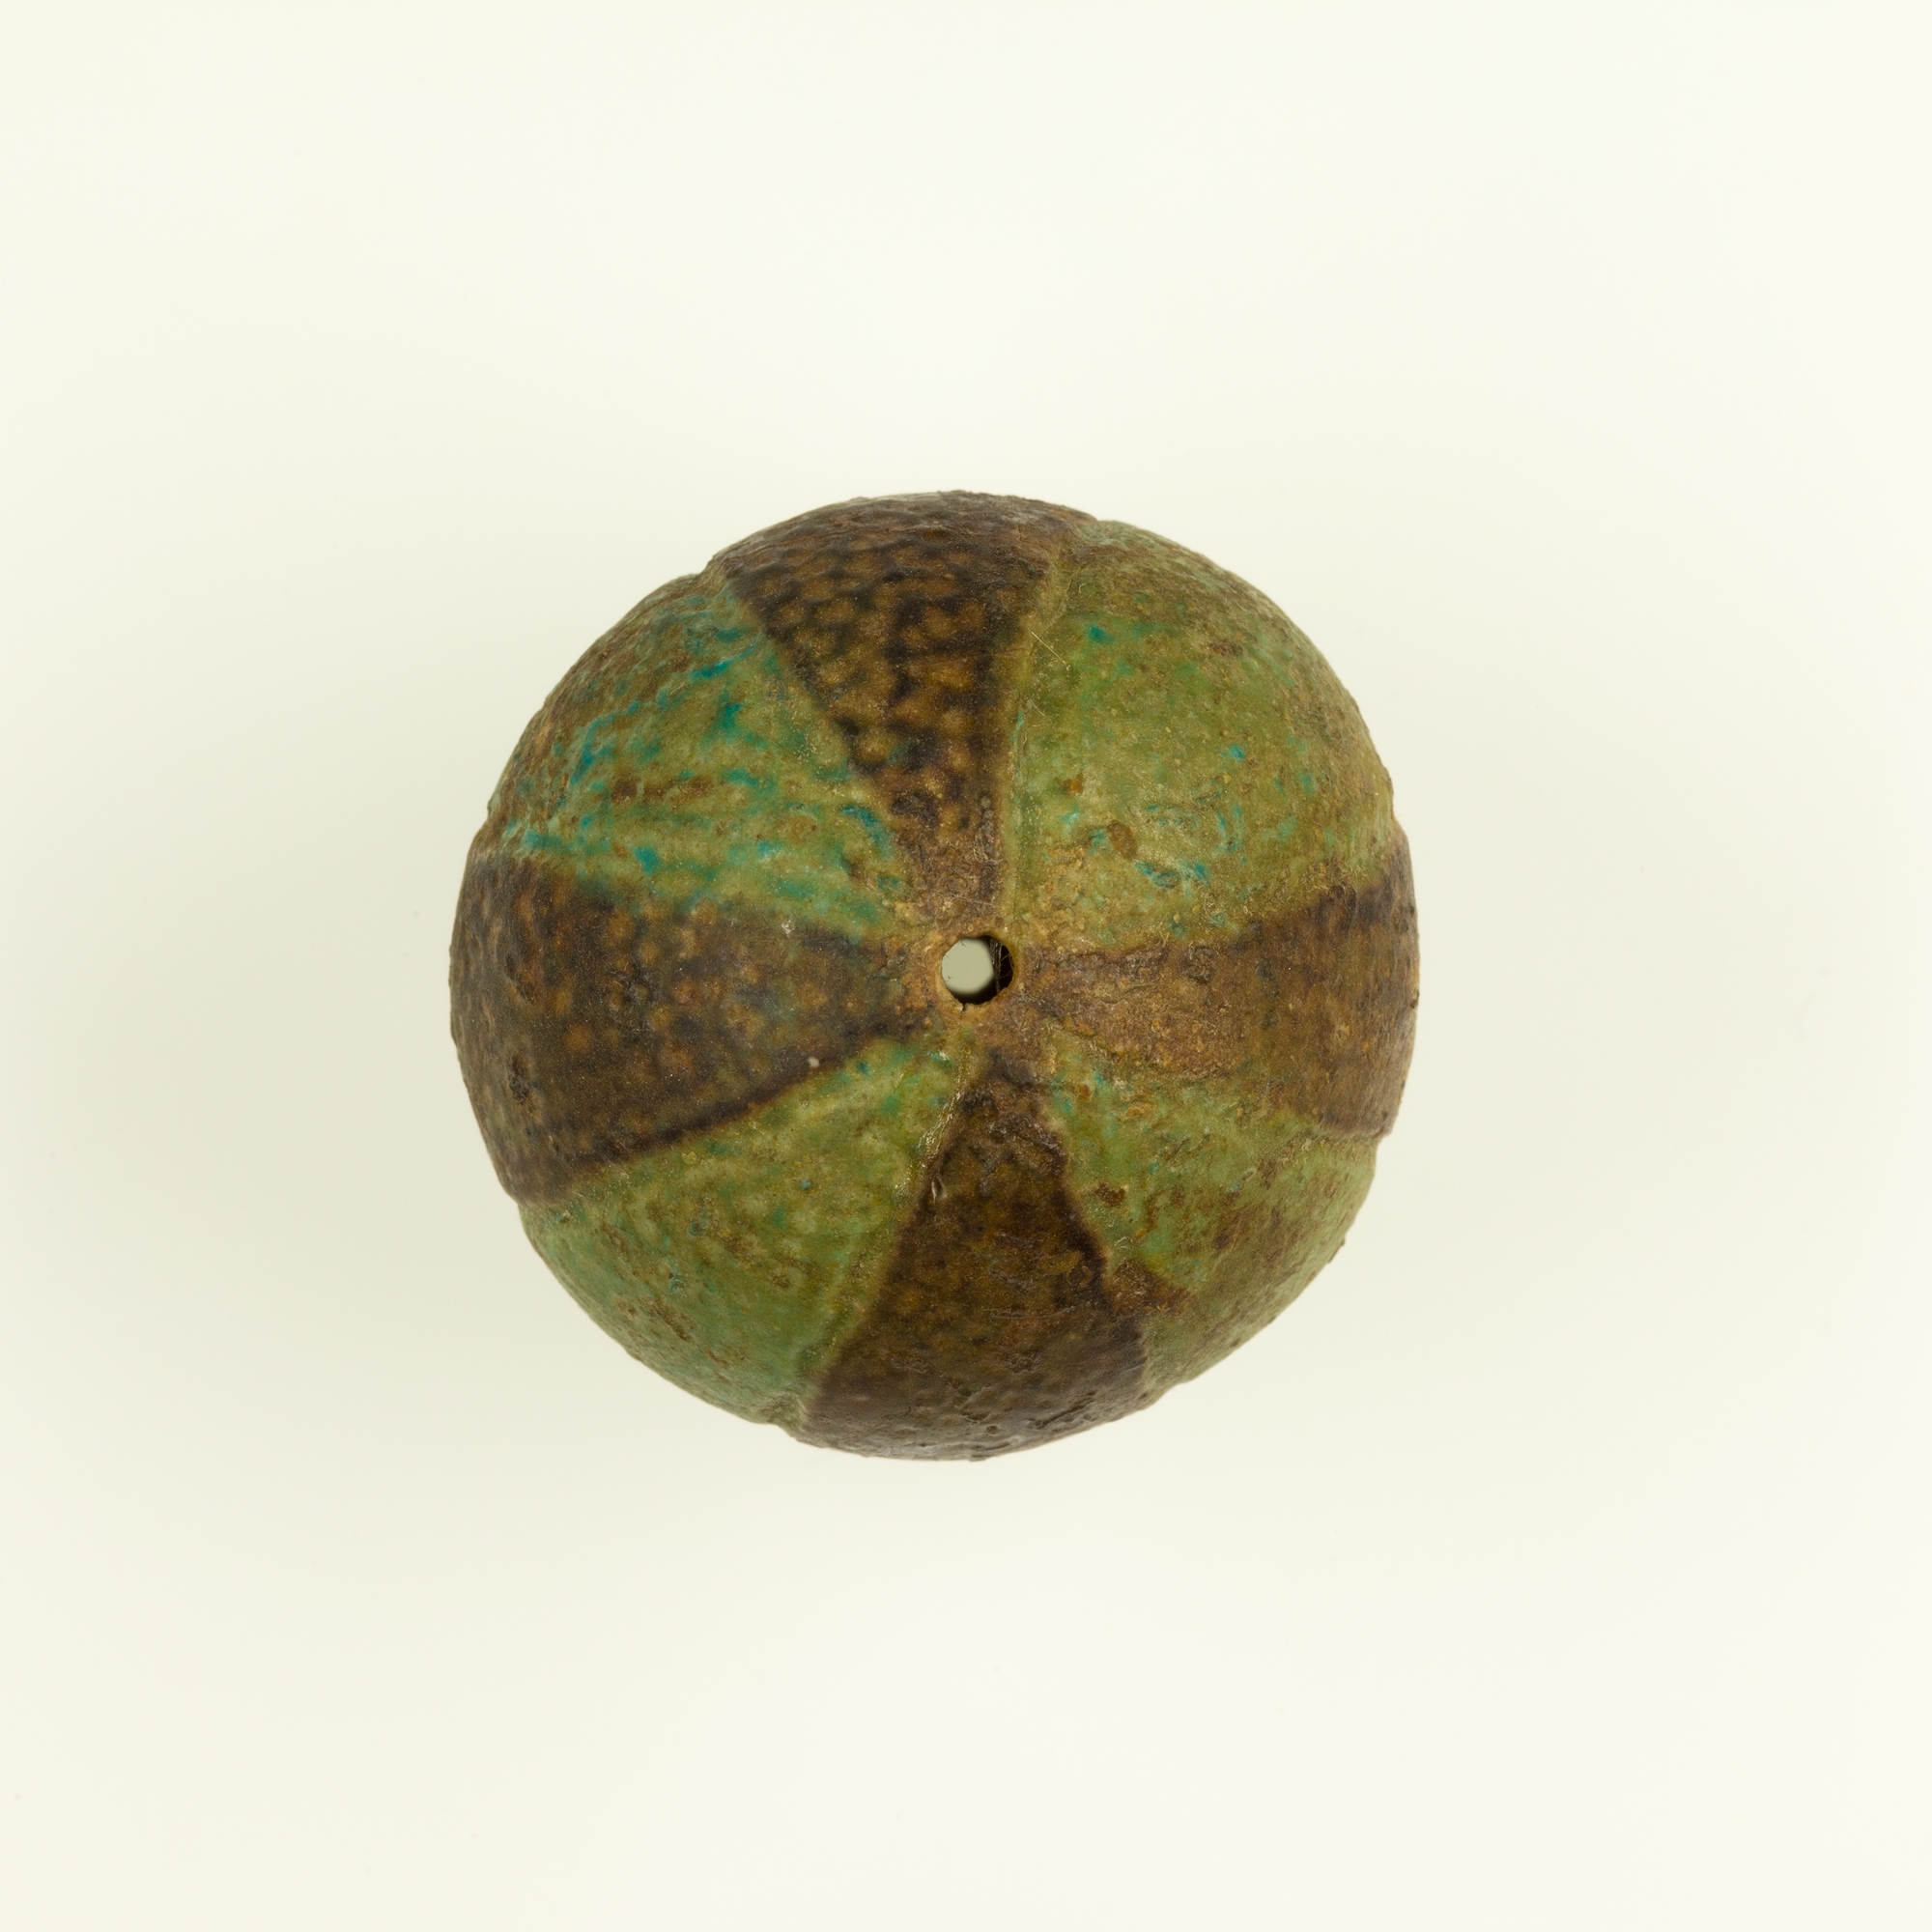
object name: bead, ball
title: Ball bead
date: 1635-1458 BCE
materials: faience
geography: egypt